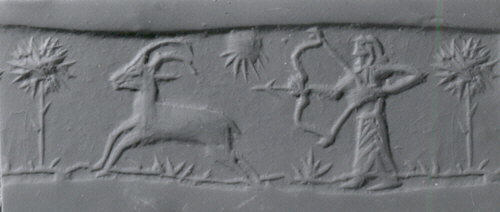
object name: cylinder seal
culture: achaemenid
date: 500-201 BCE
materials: stone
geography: iran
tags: bow and arrow,men,hunting,deer